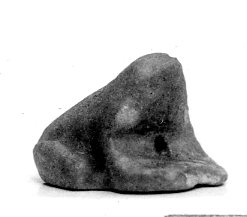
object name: amulet, frog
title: Frog amulet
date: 664-332 BCE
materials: faience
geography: egypt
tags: frogs